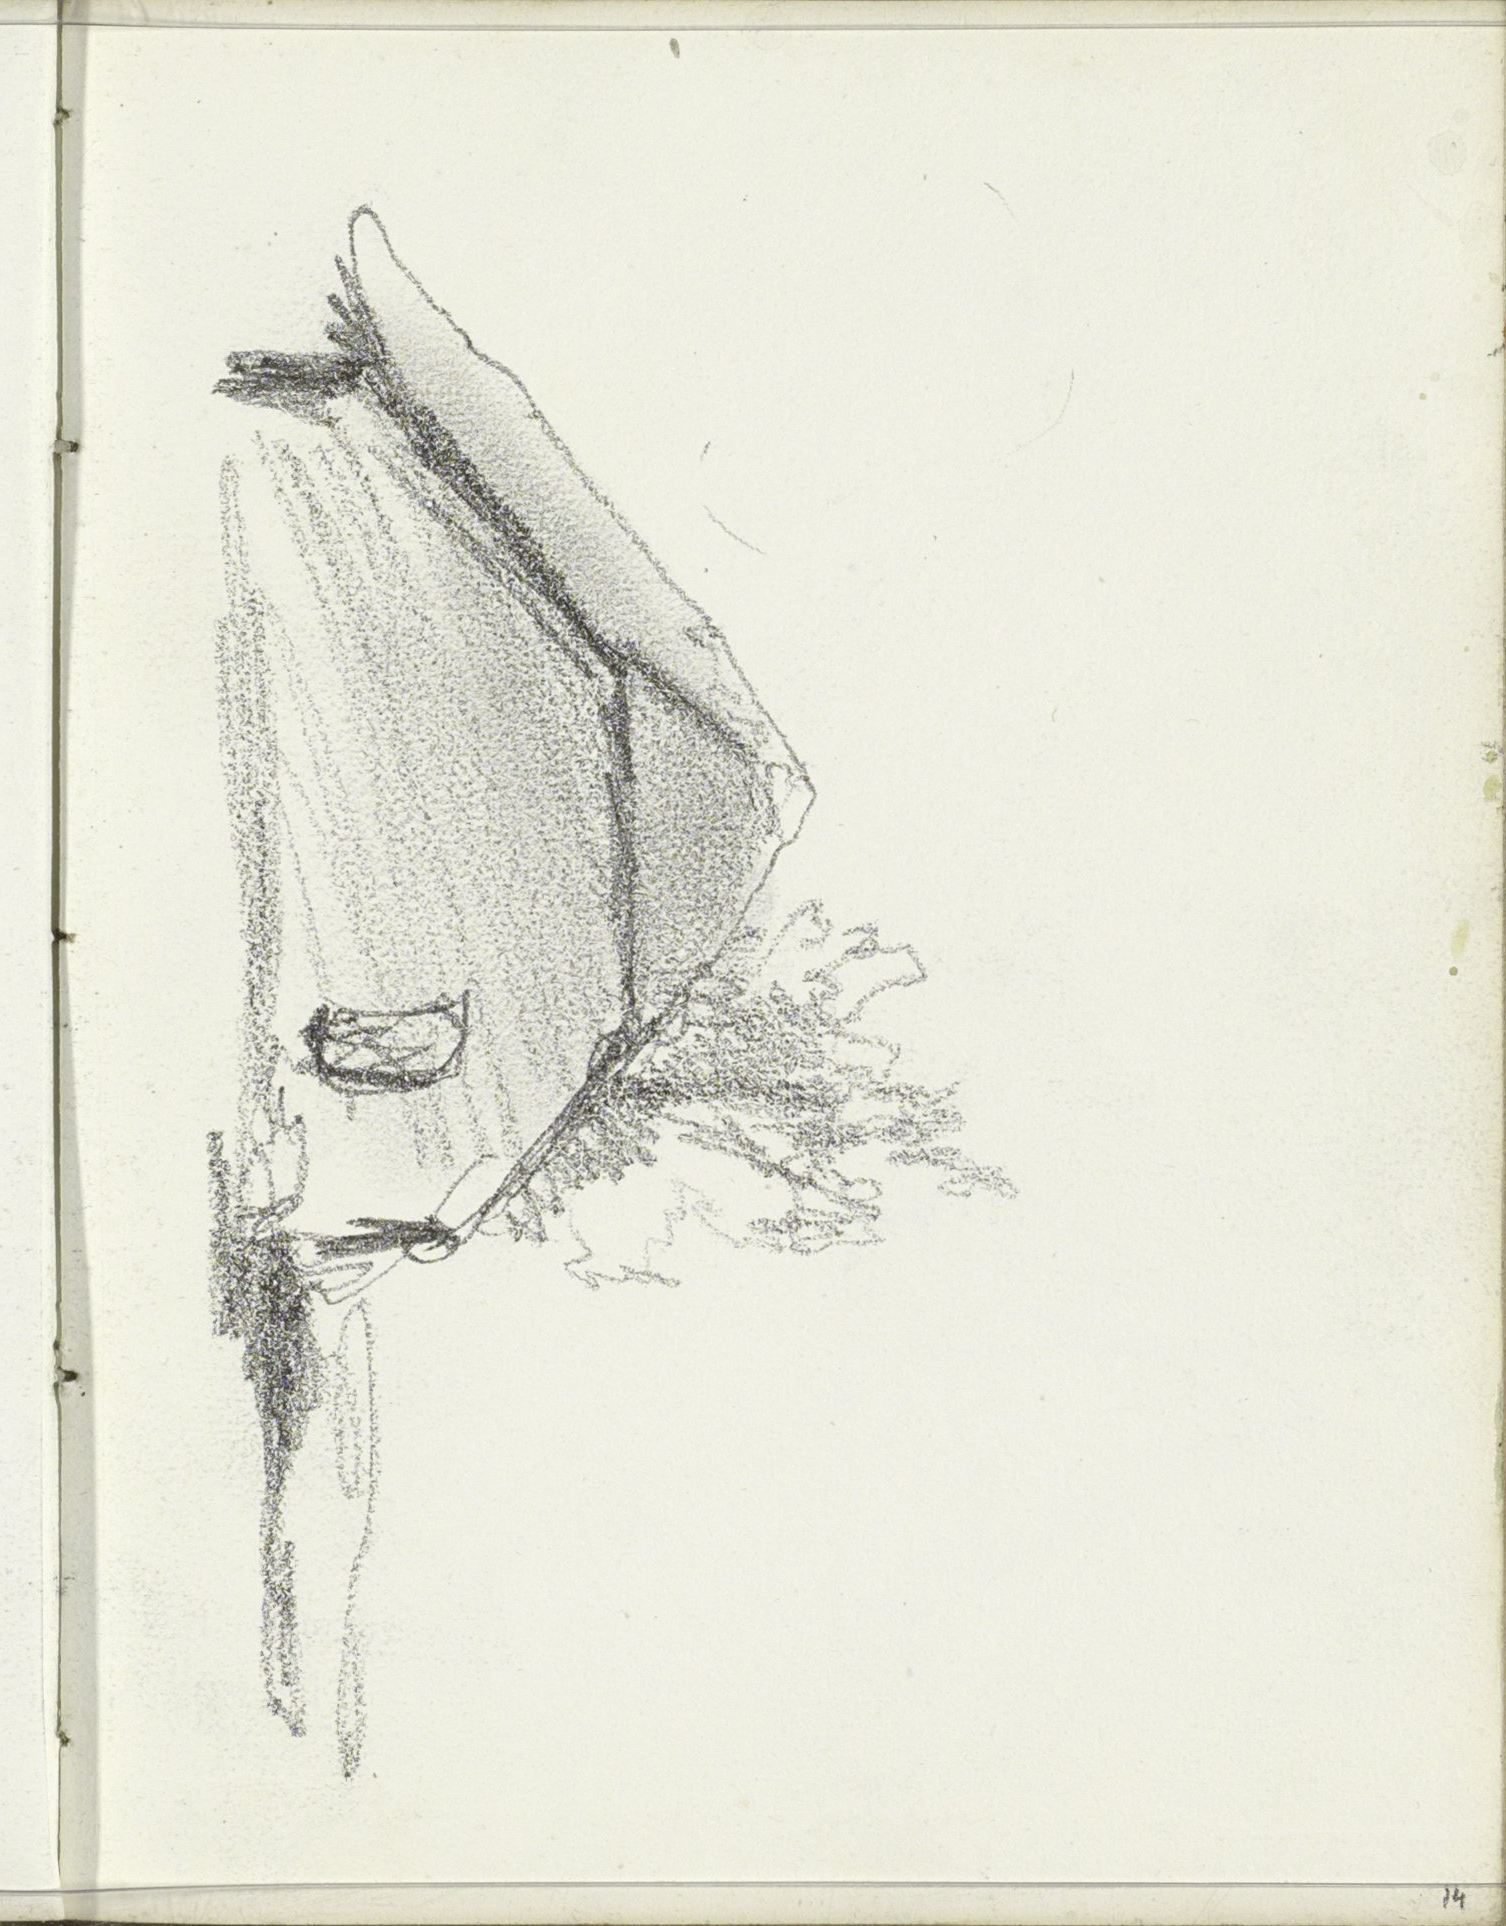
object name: sketchbook leaf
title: Huis met een rieten dak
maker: johan hendrik weissenbruch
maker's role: draughtsman, painter, print maker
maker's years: 1824-1903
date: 1834-1903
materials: paper, pencil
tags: cottage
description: Blad 14 recto uit een schetsboek met 34 bladen.